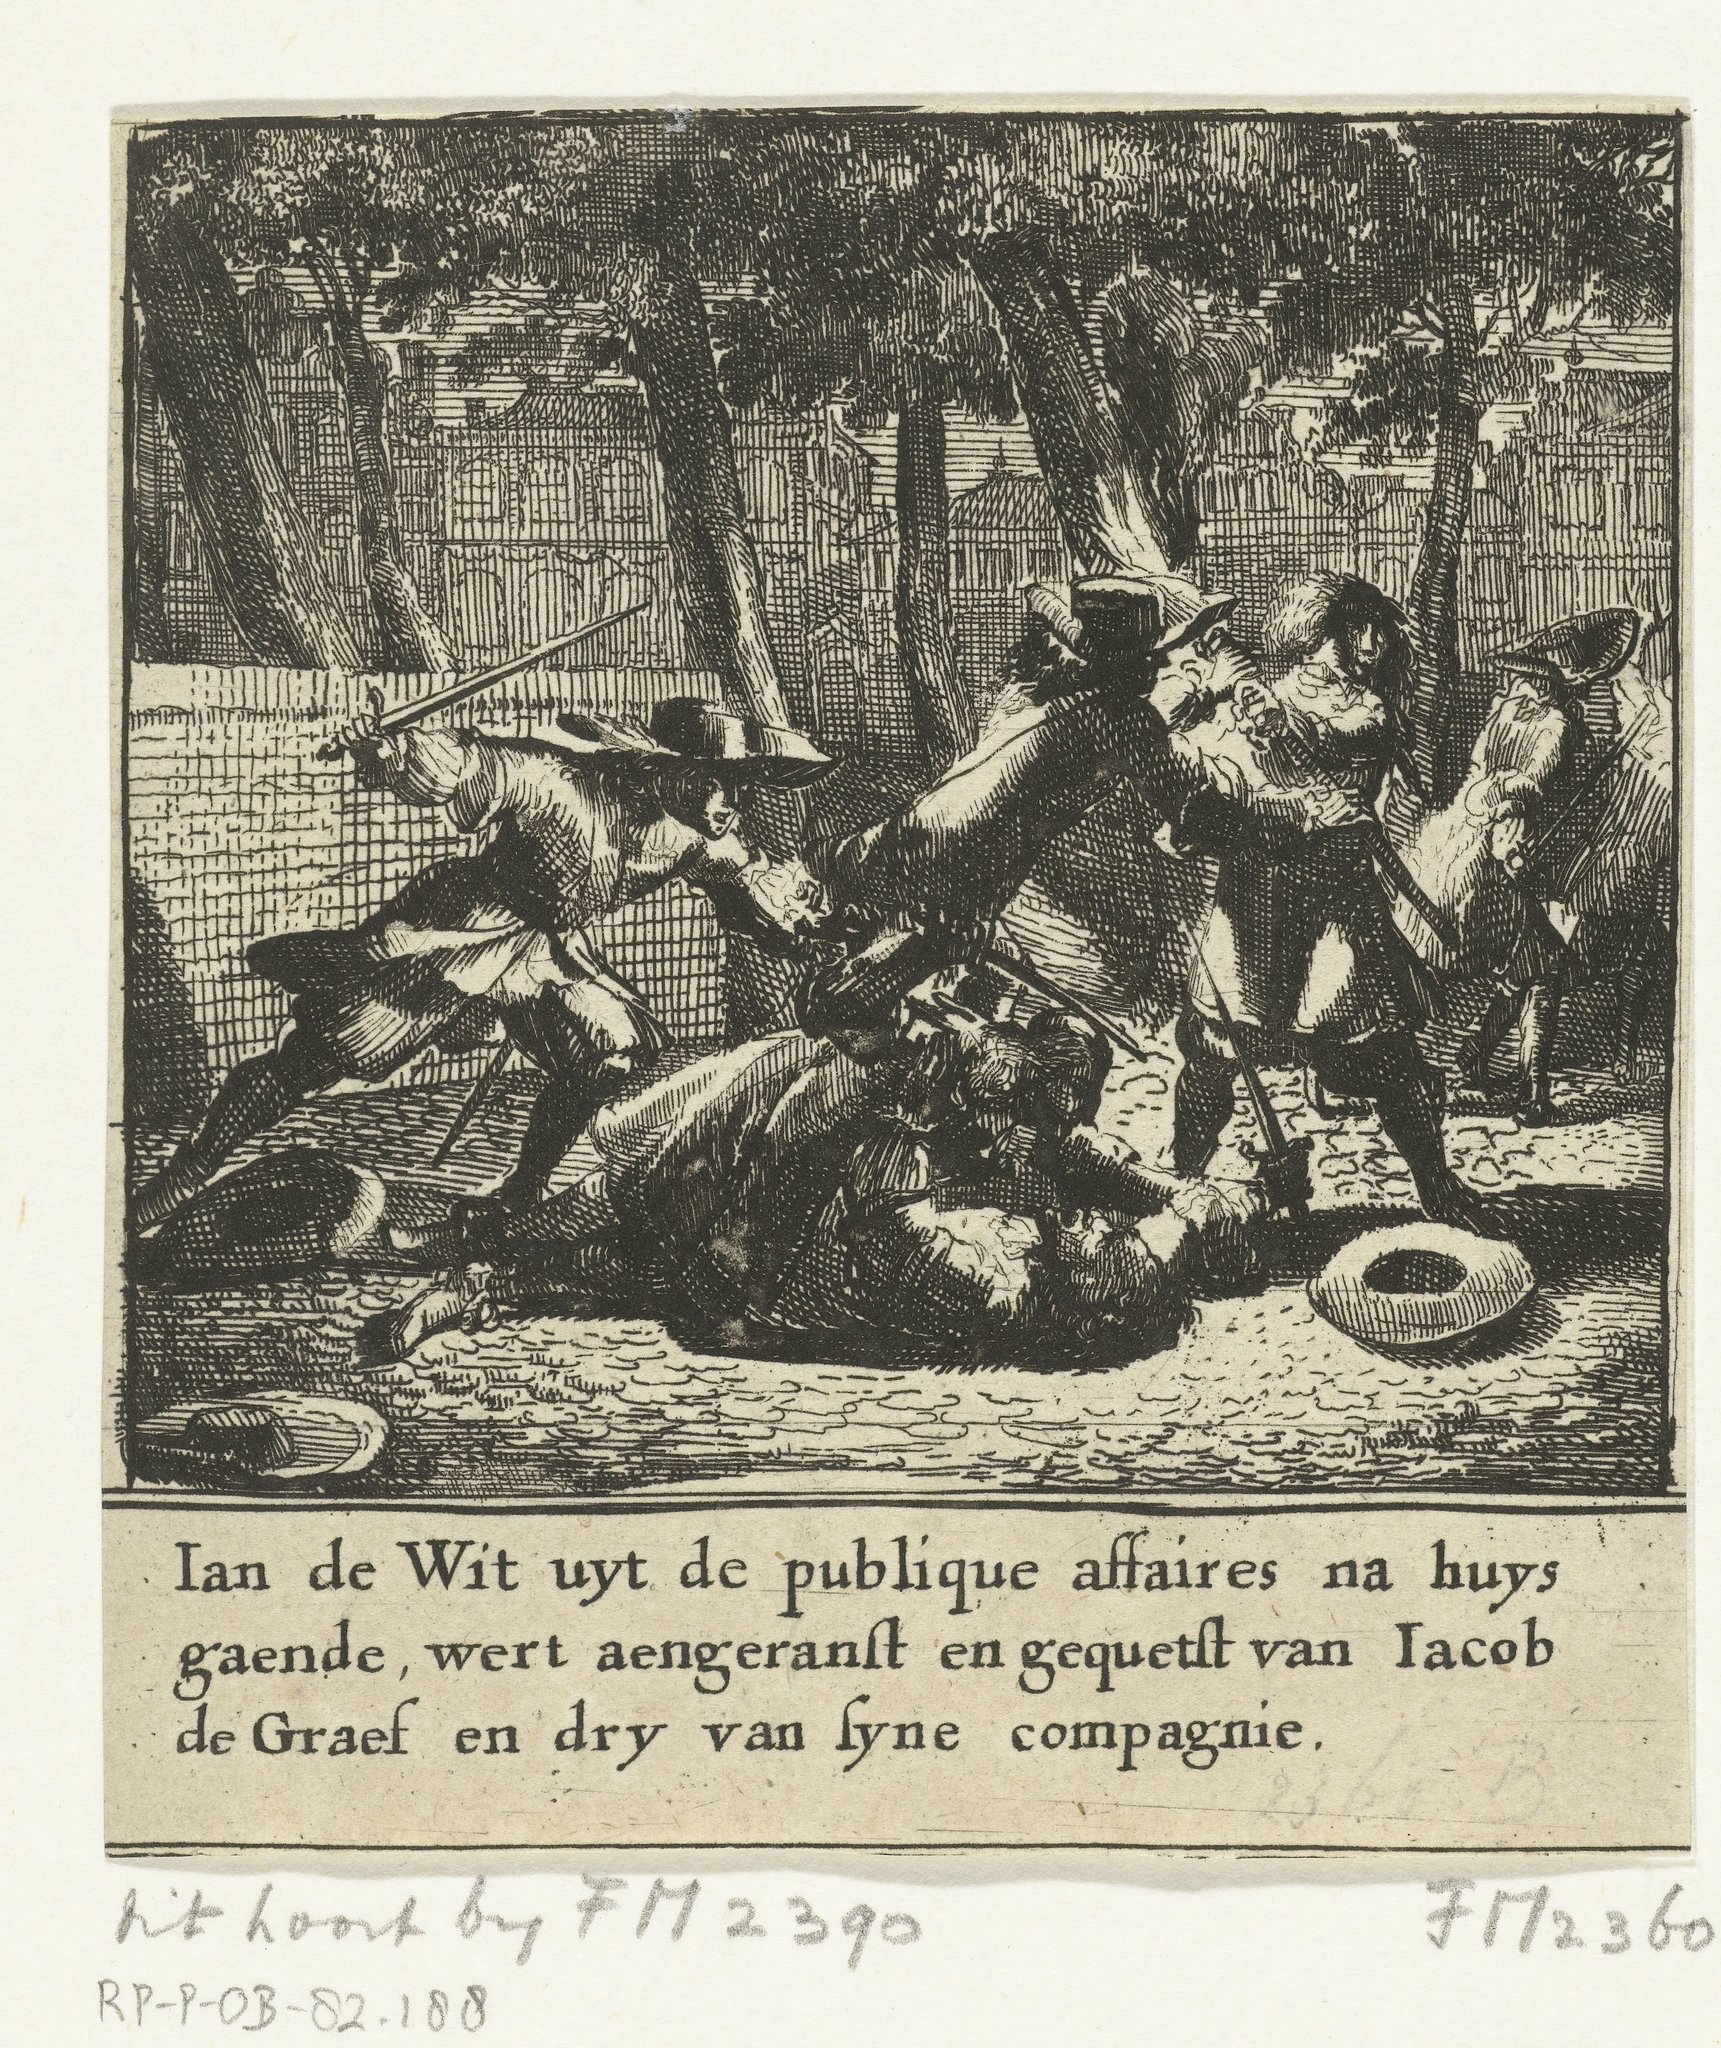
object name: history print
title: Jan de Wit uyt de publique affaires na huys gaende, wert aengeranst en gequetst van Jacob de Graef en dry van syne compagnie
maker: romeyn de hooghe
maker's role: draughtsman, goldsmith, painter, print maker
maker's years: 1645-1708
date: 1675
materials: paper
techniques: etching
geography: northern netherlands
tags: the hague, politician, johan de witt, fighting, rampjaar (disaster year)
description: Raadpensionaris Johan de Witt wordt op straat aangevallen door een groep gewapende mannen onder leiding van Jacob de Graef en raakt zwaar gewond, juni 1672. Fragment van de grote prent over de gebroeders De Witt: Witten Wonder Spiegel (1675).